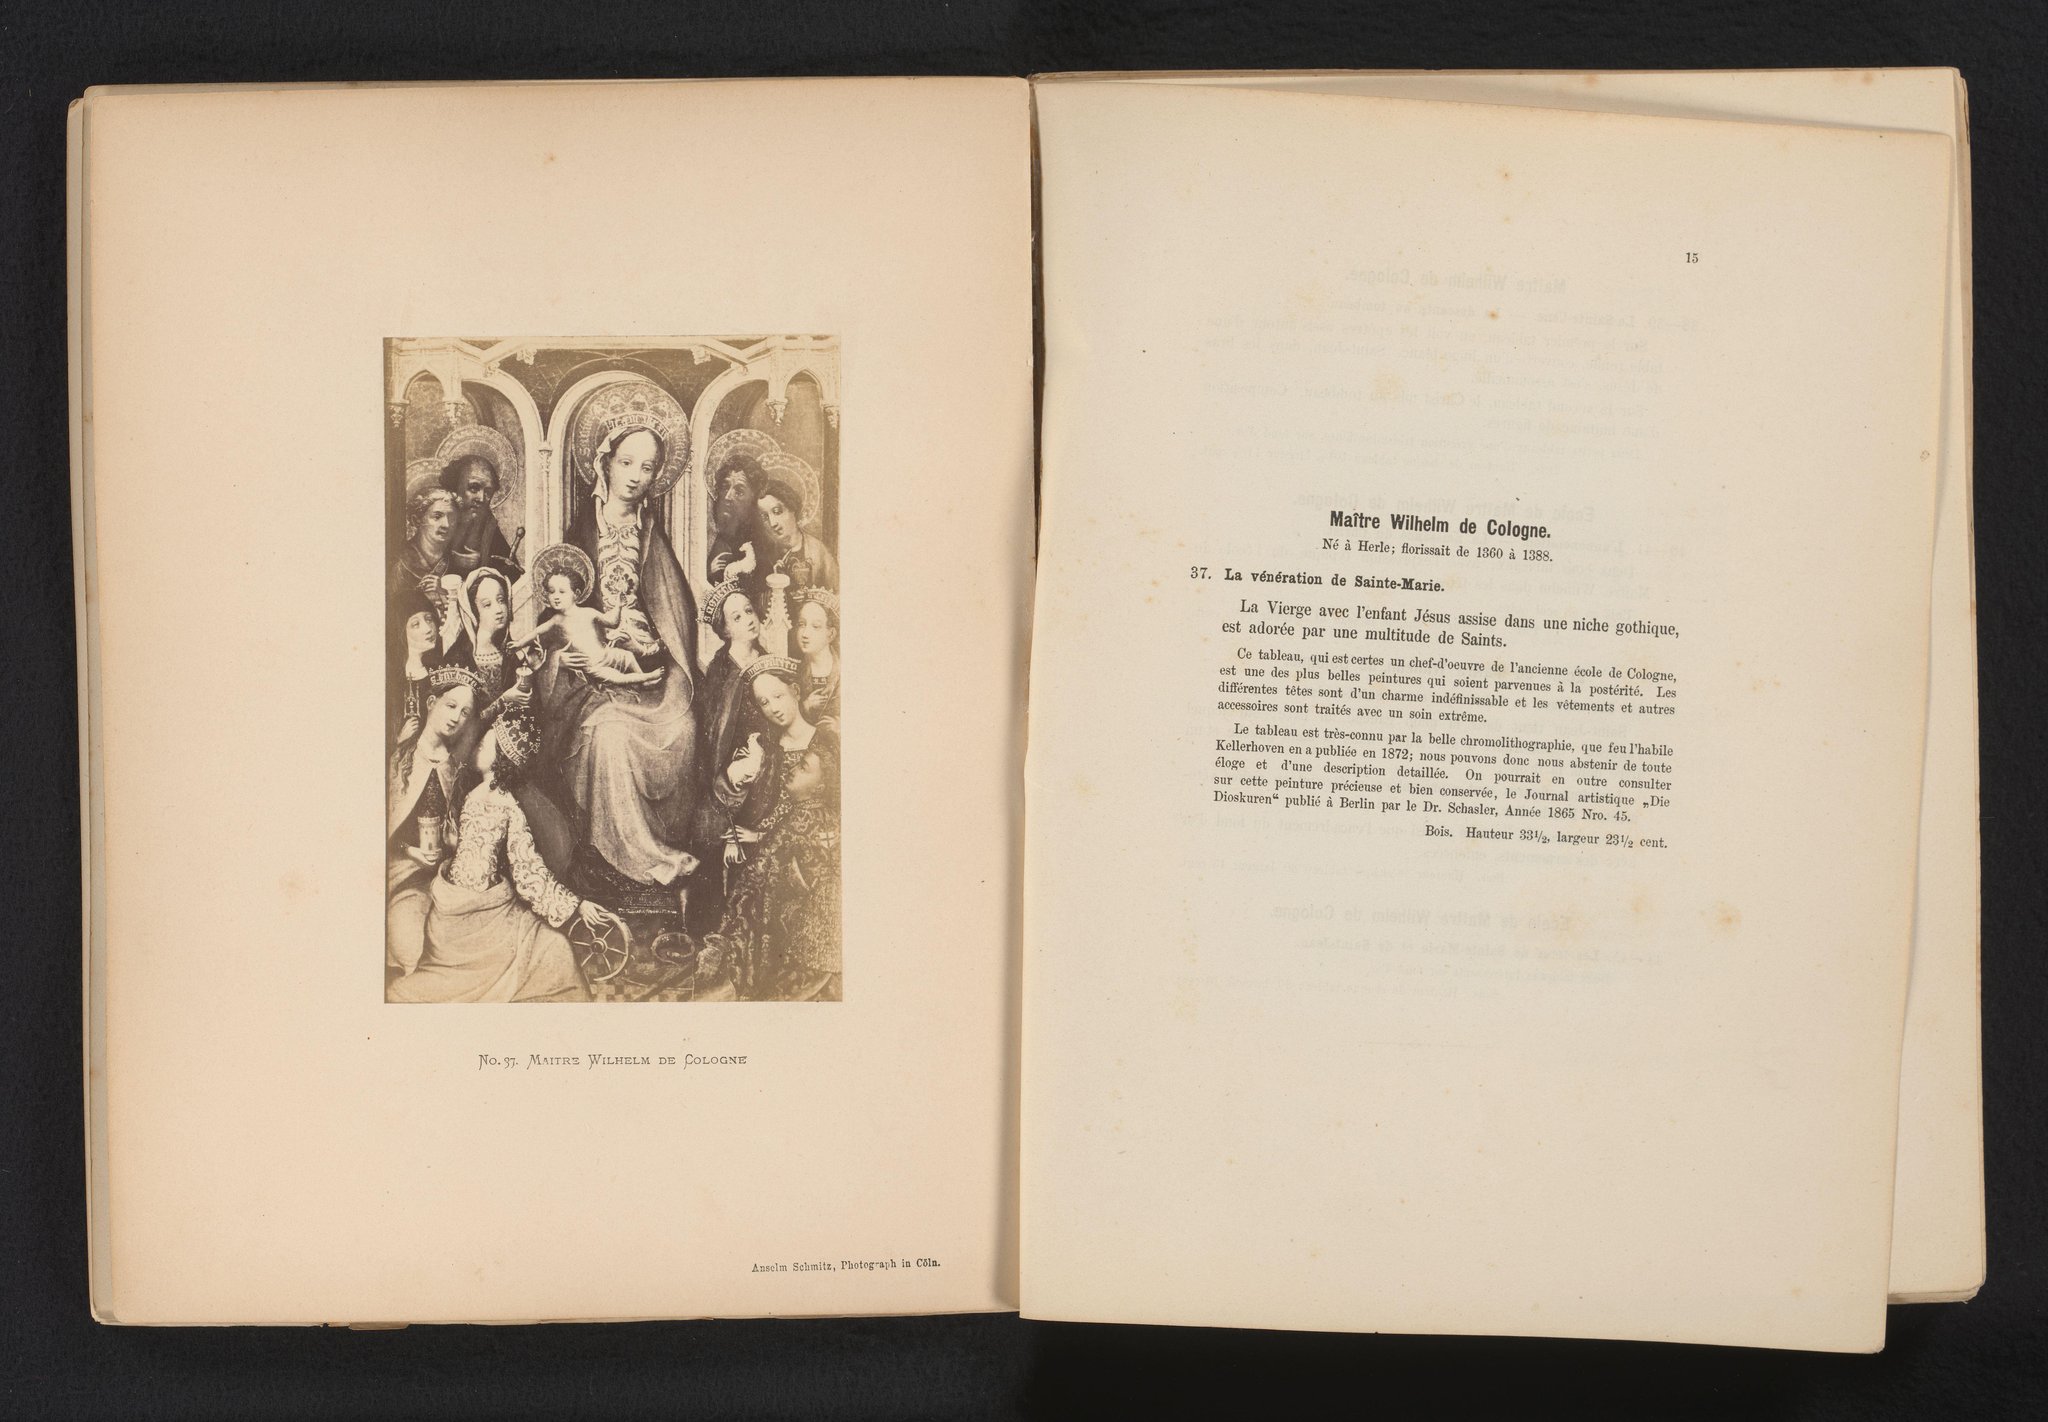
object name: page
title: Fotoreproductie van een schilderij van de verering van Maria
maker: anselm schmitz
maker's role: publisher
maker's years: 1831-1903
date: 1871-1876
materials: photographic support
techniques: albumen print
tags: madonna: i.e. mary with the christ-child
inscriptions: inscription: ‘No. 37. Maitre Wilhelm de Cologne’